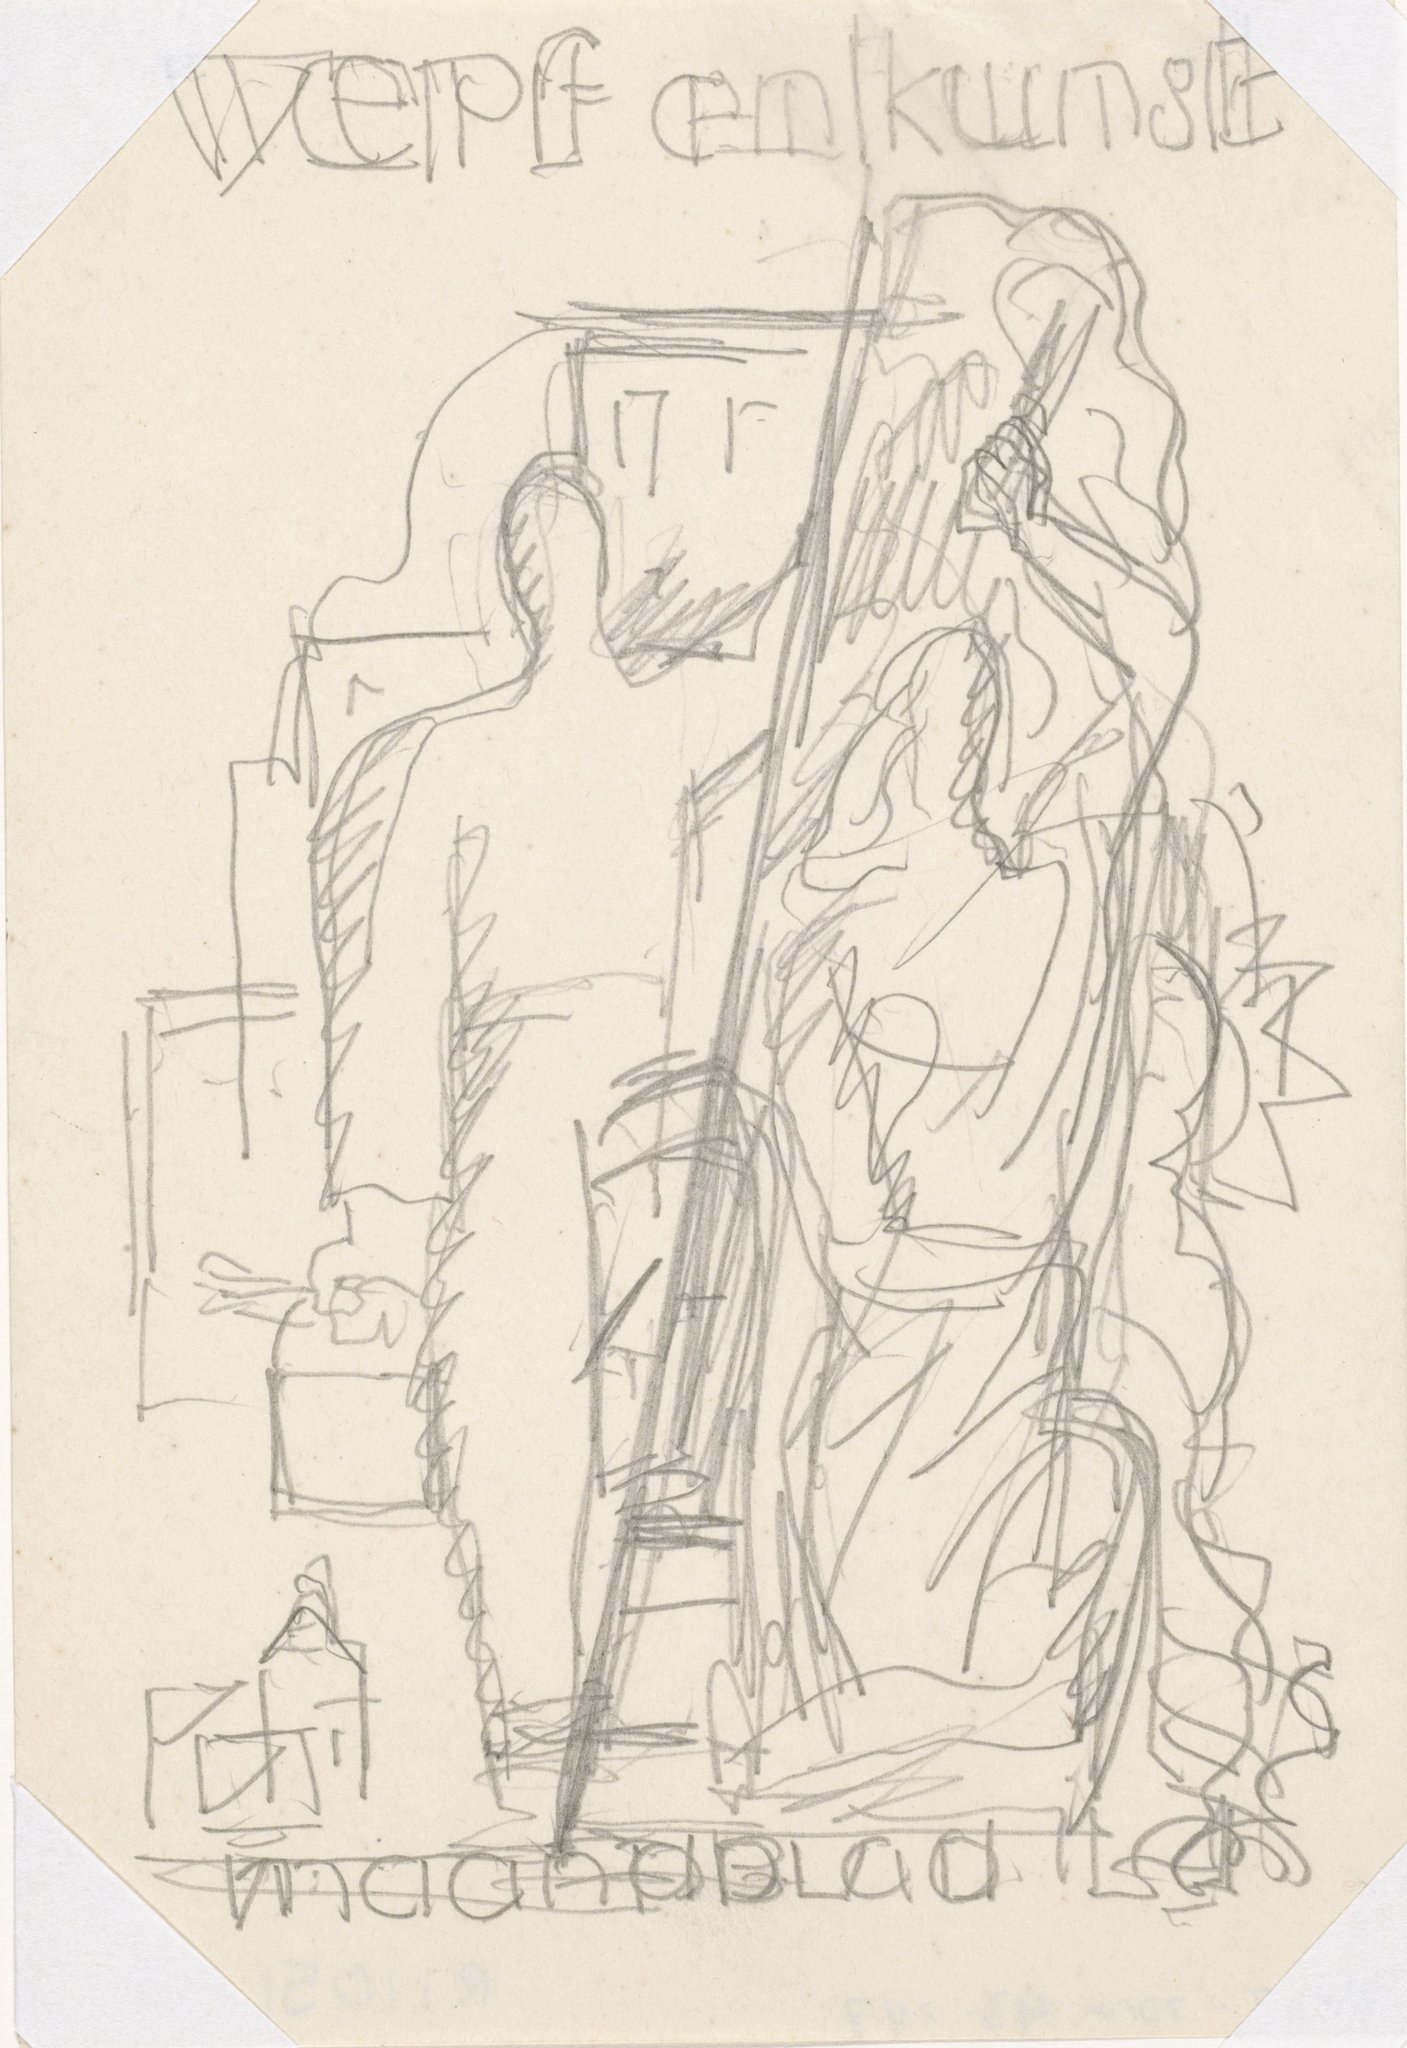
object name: drawing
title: Maandblad Verf en Kunst van P.A. Regnault (ontwerp)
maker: leo gestel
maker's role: draughtsman, print maker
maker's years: 1881-1941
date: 1931-1941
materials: paper, pencil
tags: painting (including book-illumination, miniature-painting)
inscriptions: title: ‘VERF EN KUNST // maandblad’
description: Een man op een ladder (in het midden) met verfblik en kwasten links, een vrouw met een fakkel rechts. Ontwerp voor het Maandblad Verf en Kunst van P.A. Regnault.